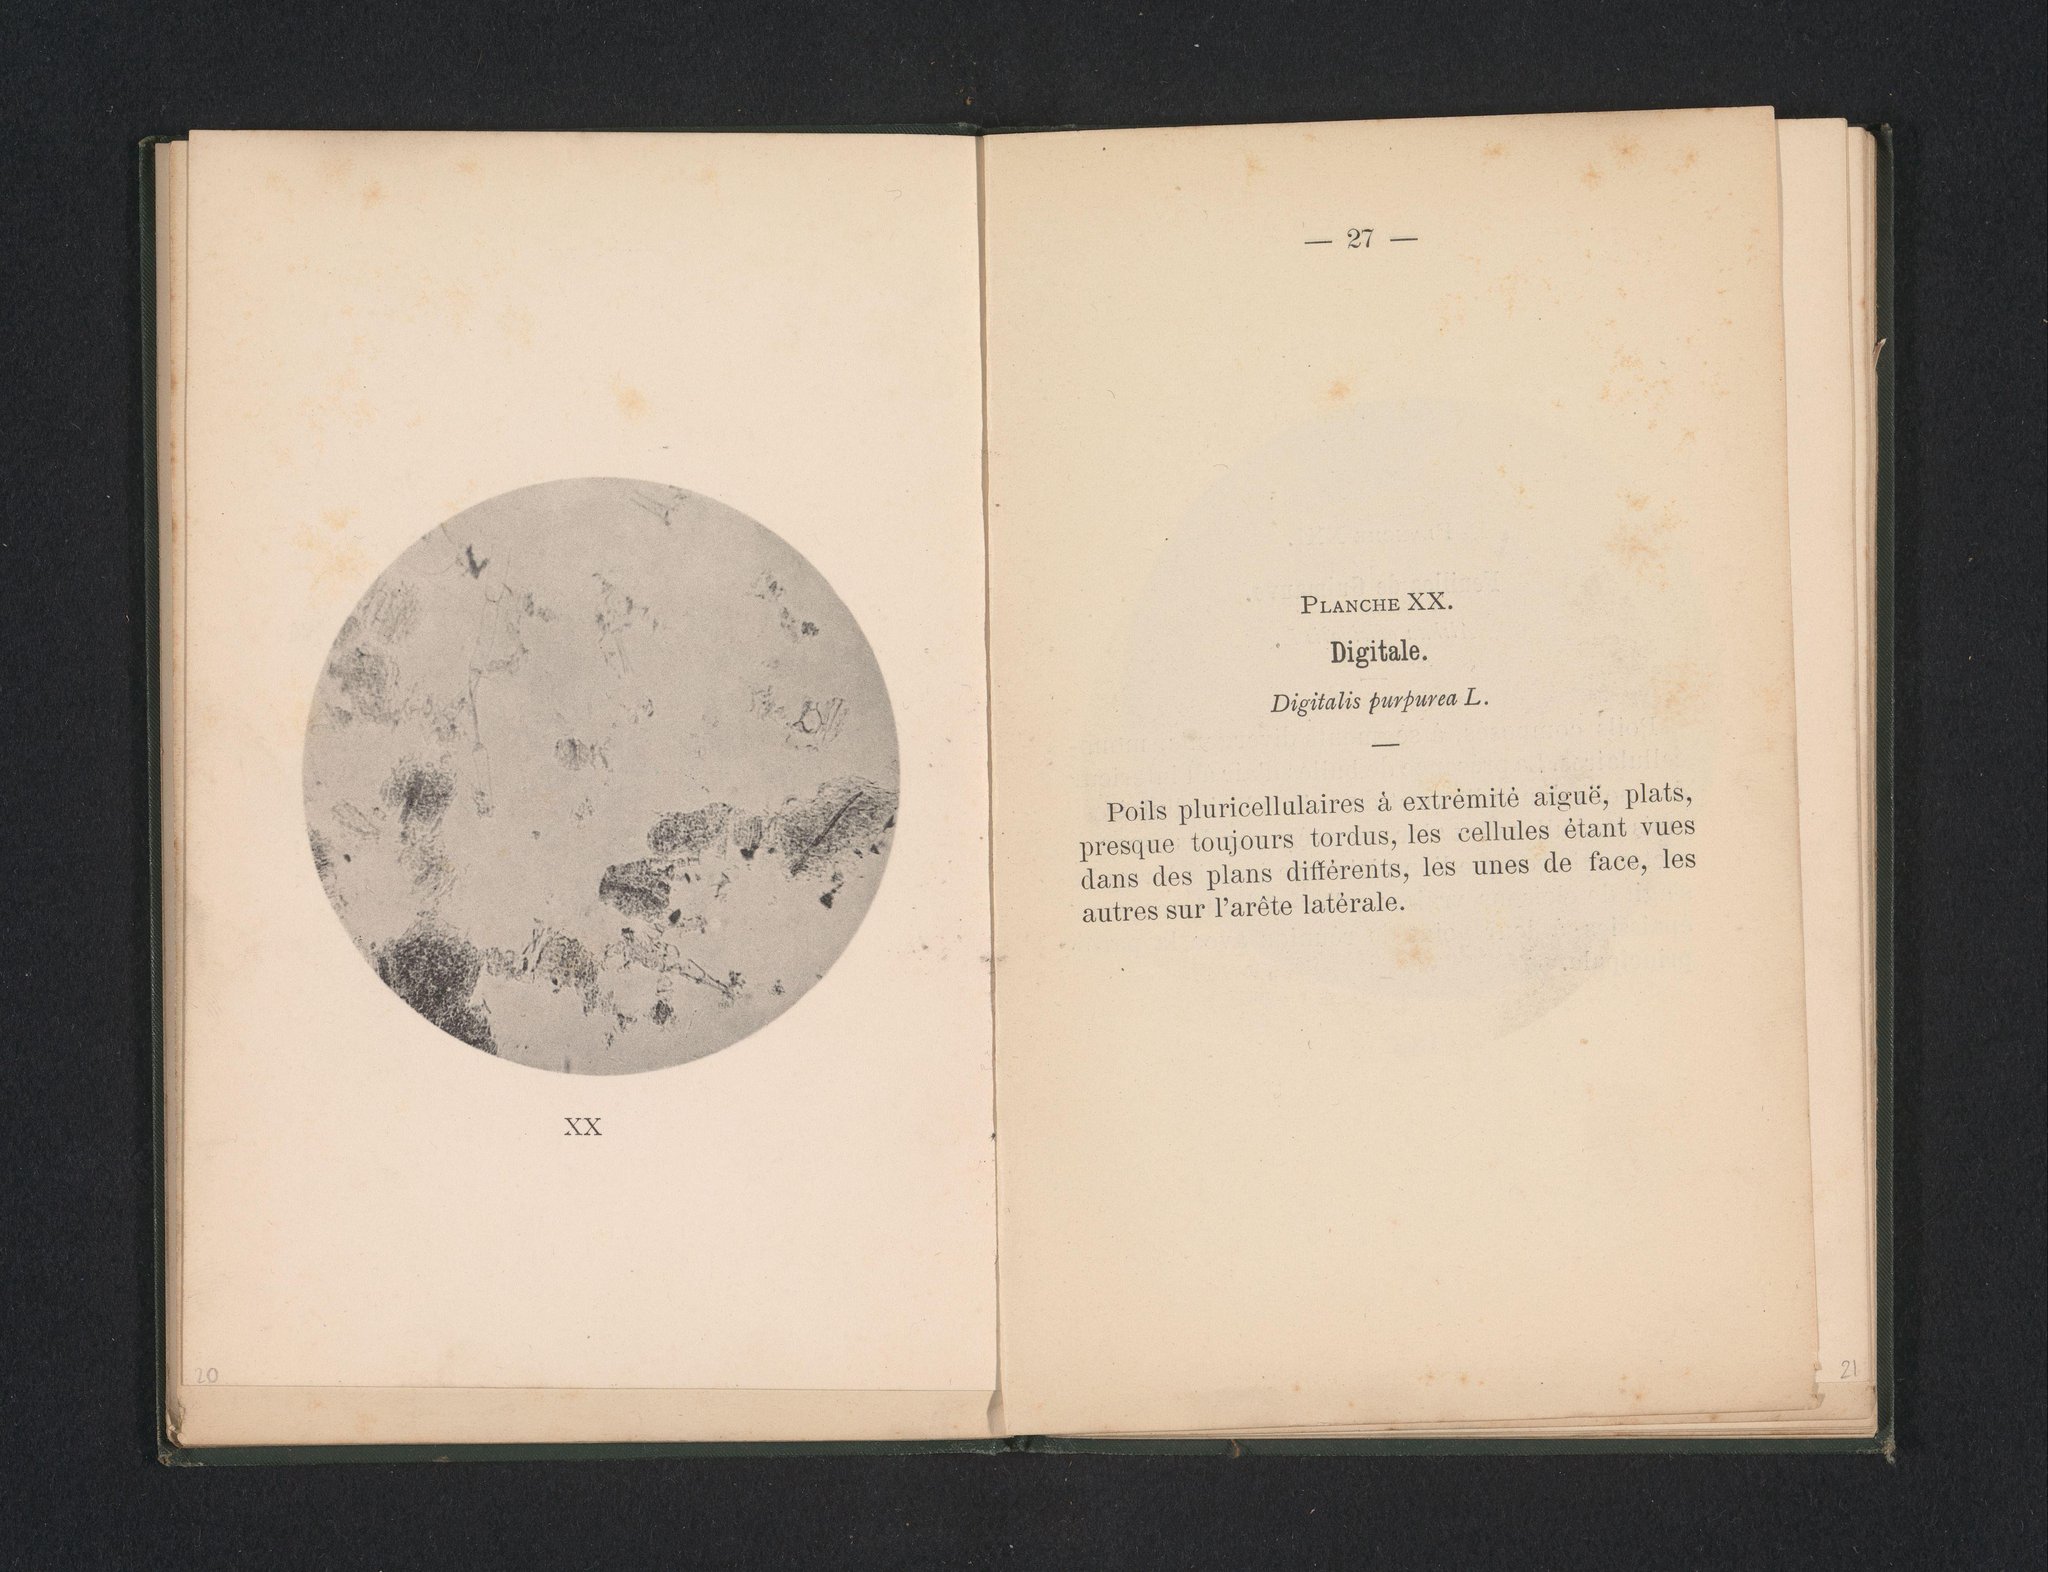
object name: photomechanical print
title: Microscopische weergave van vingerhoedskruid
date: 1891-1896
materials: paper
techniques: photograph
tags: microscope (+ scientific research)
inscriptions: number: ‘XX’